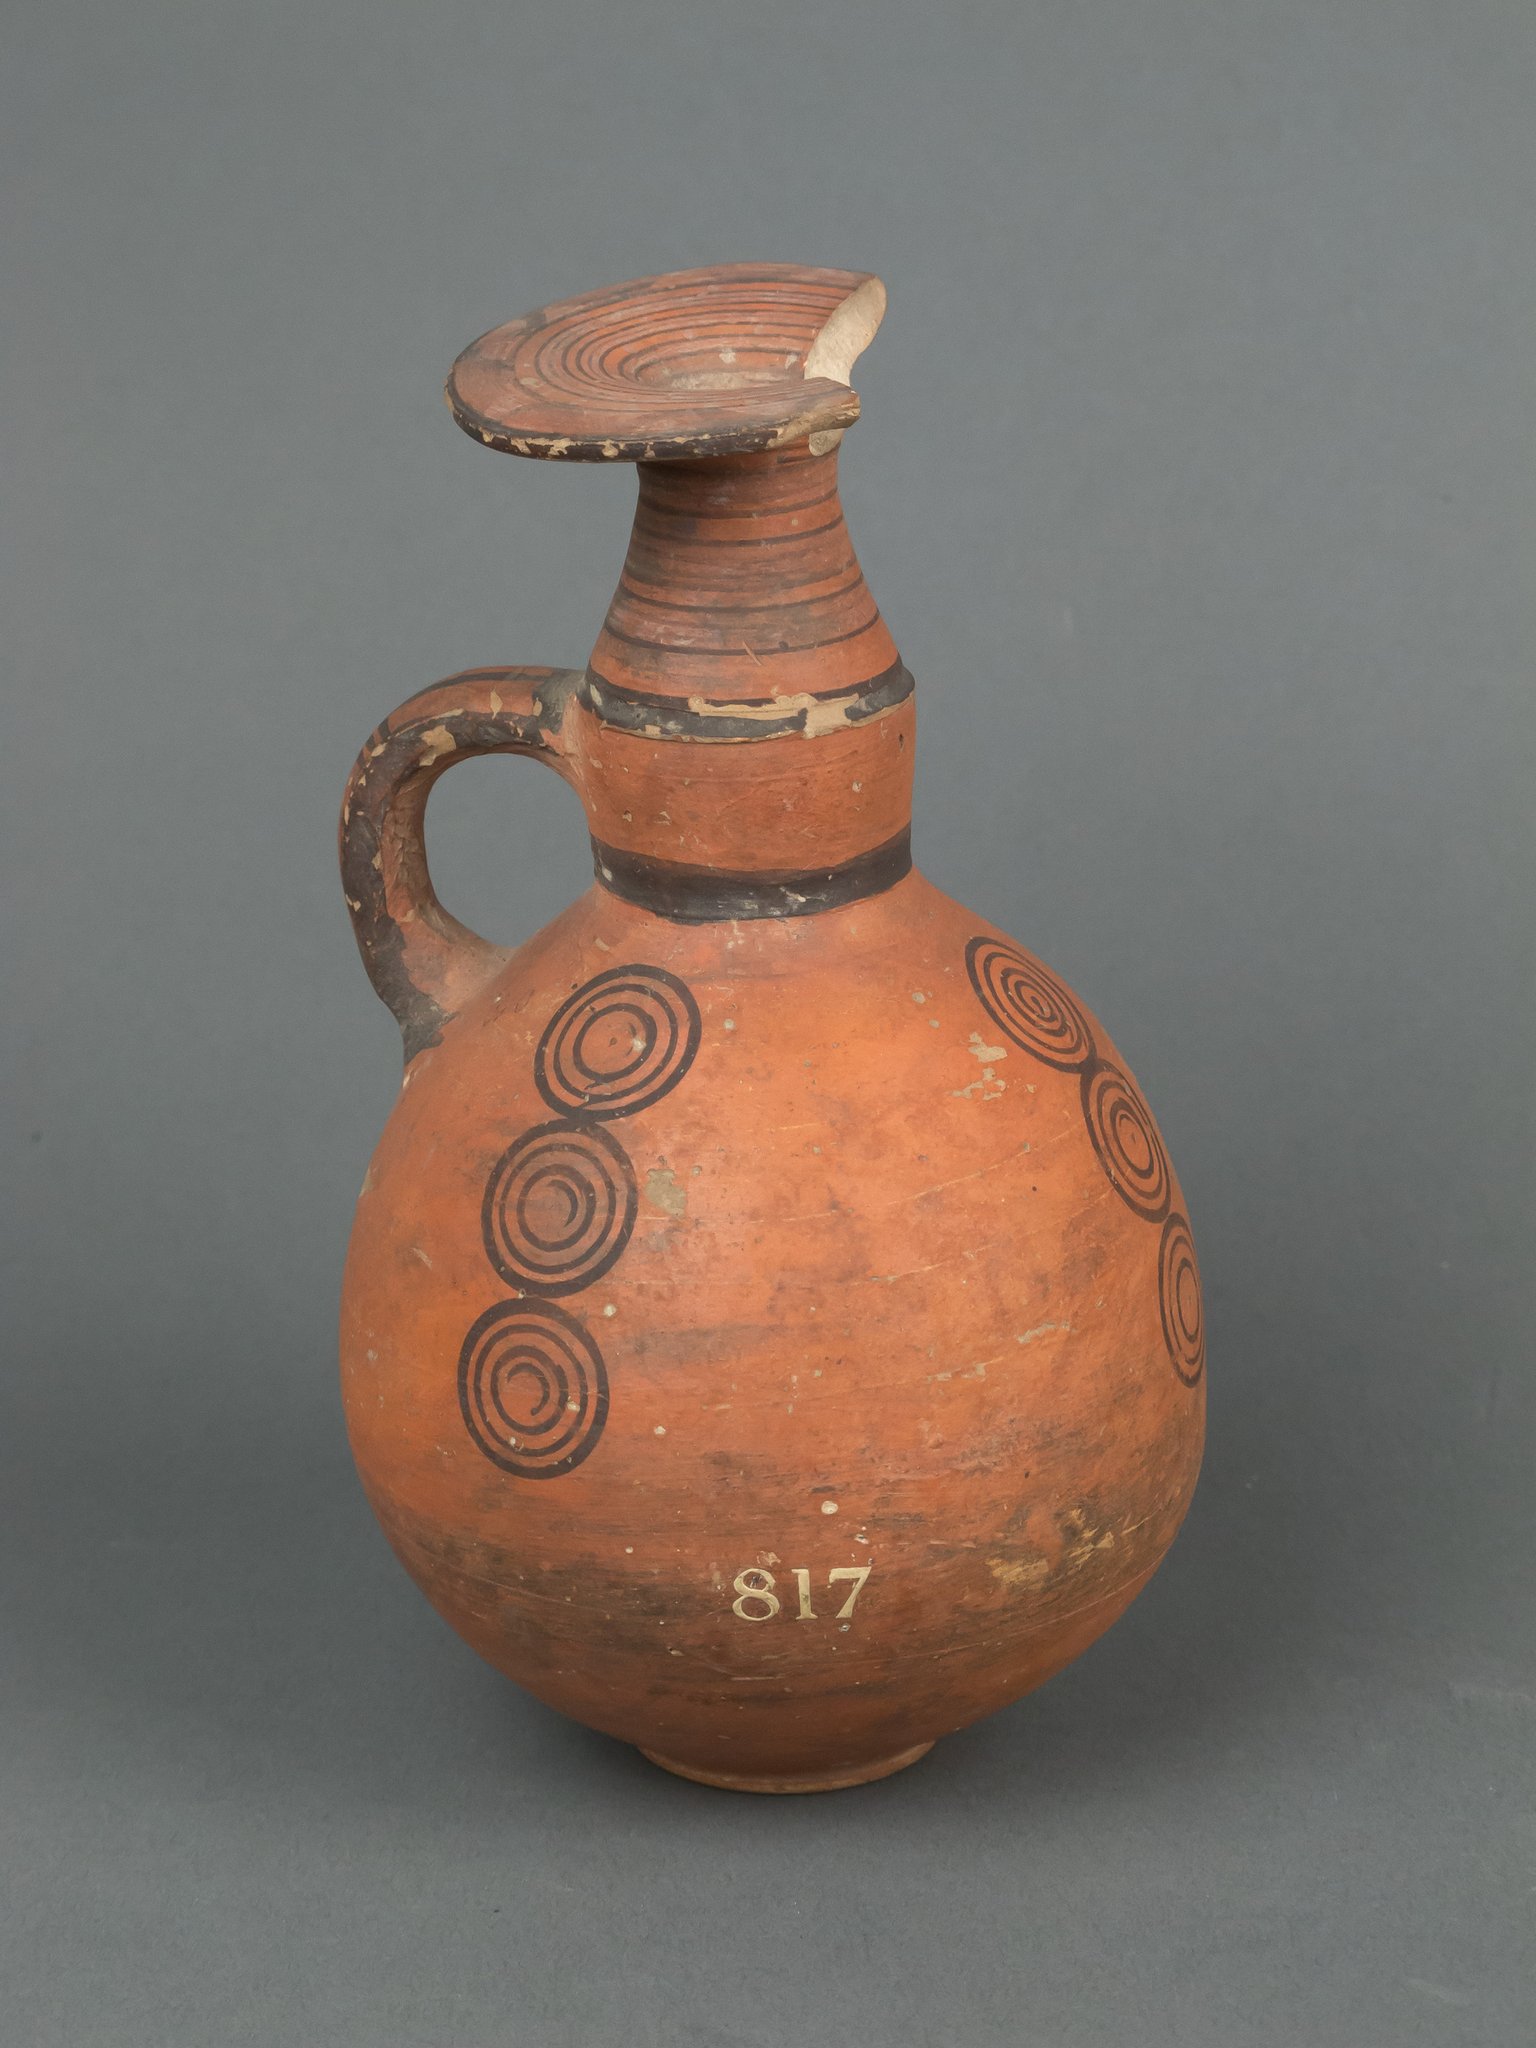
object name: jug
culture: cypriot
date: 600-480 BCE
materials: terracotta